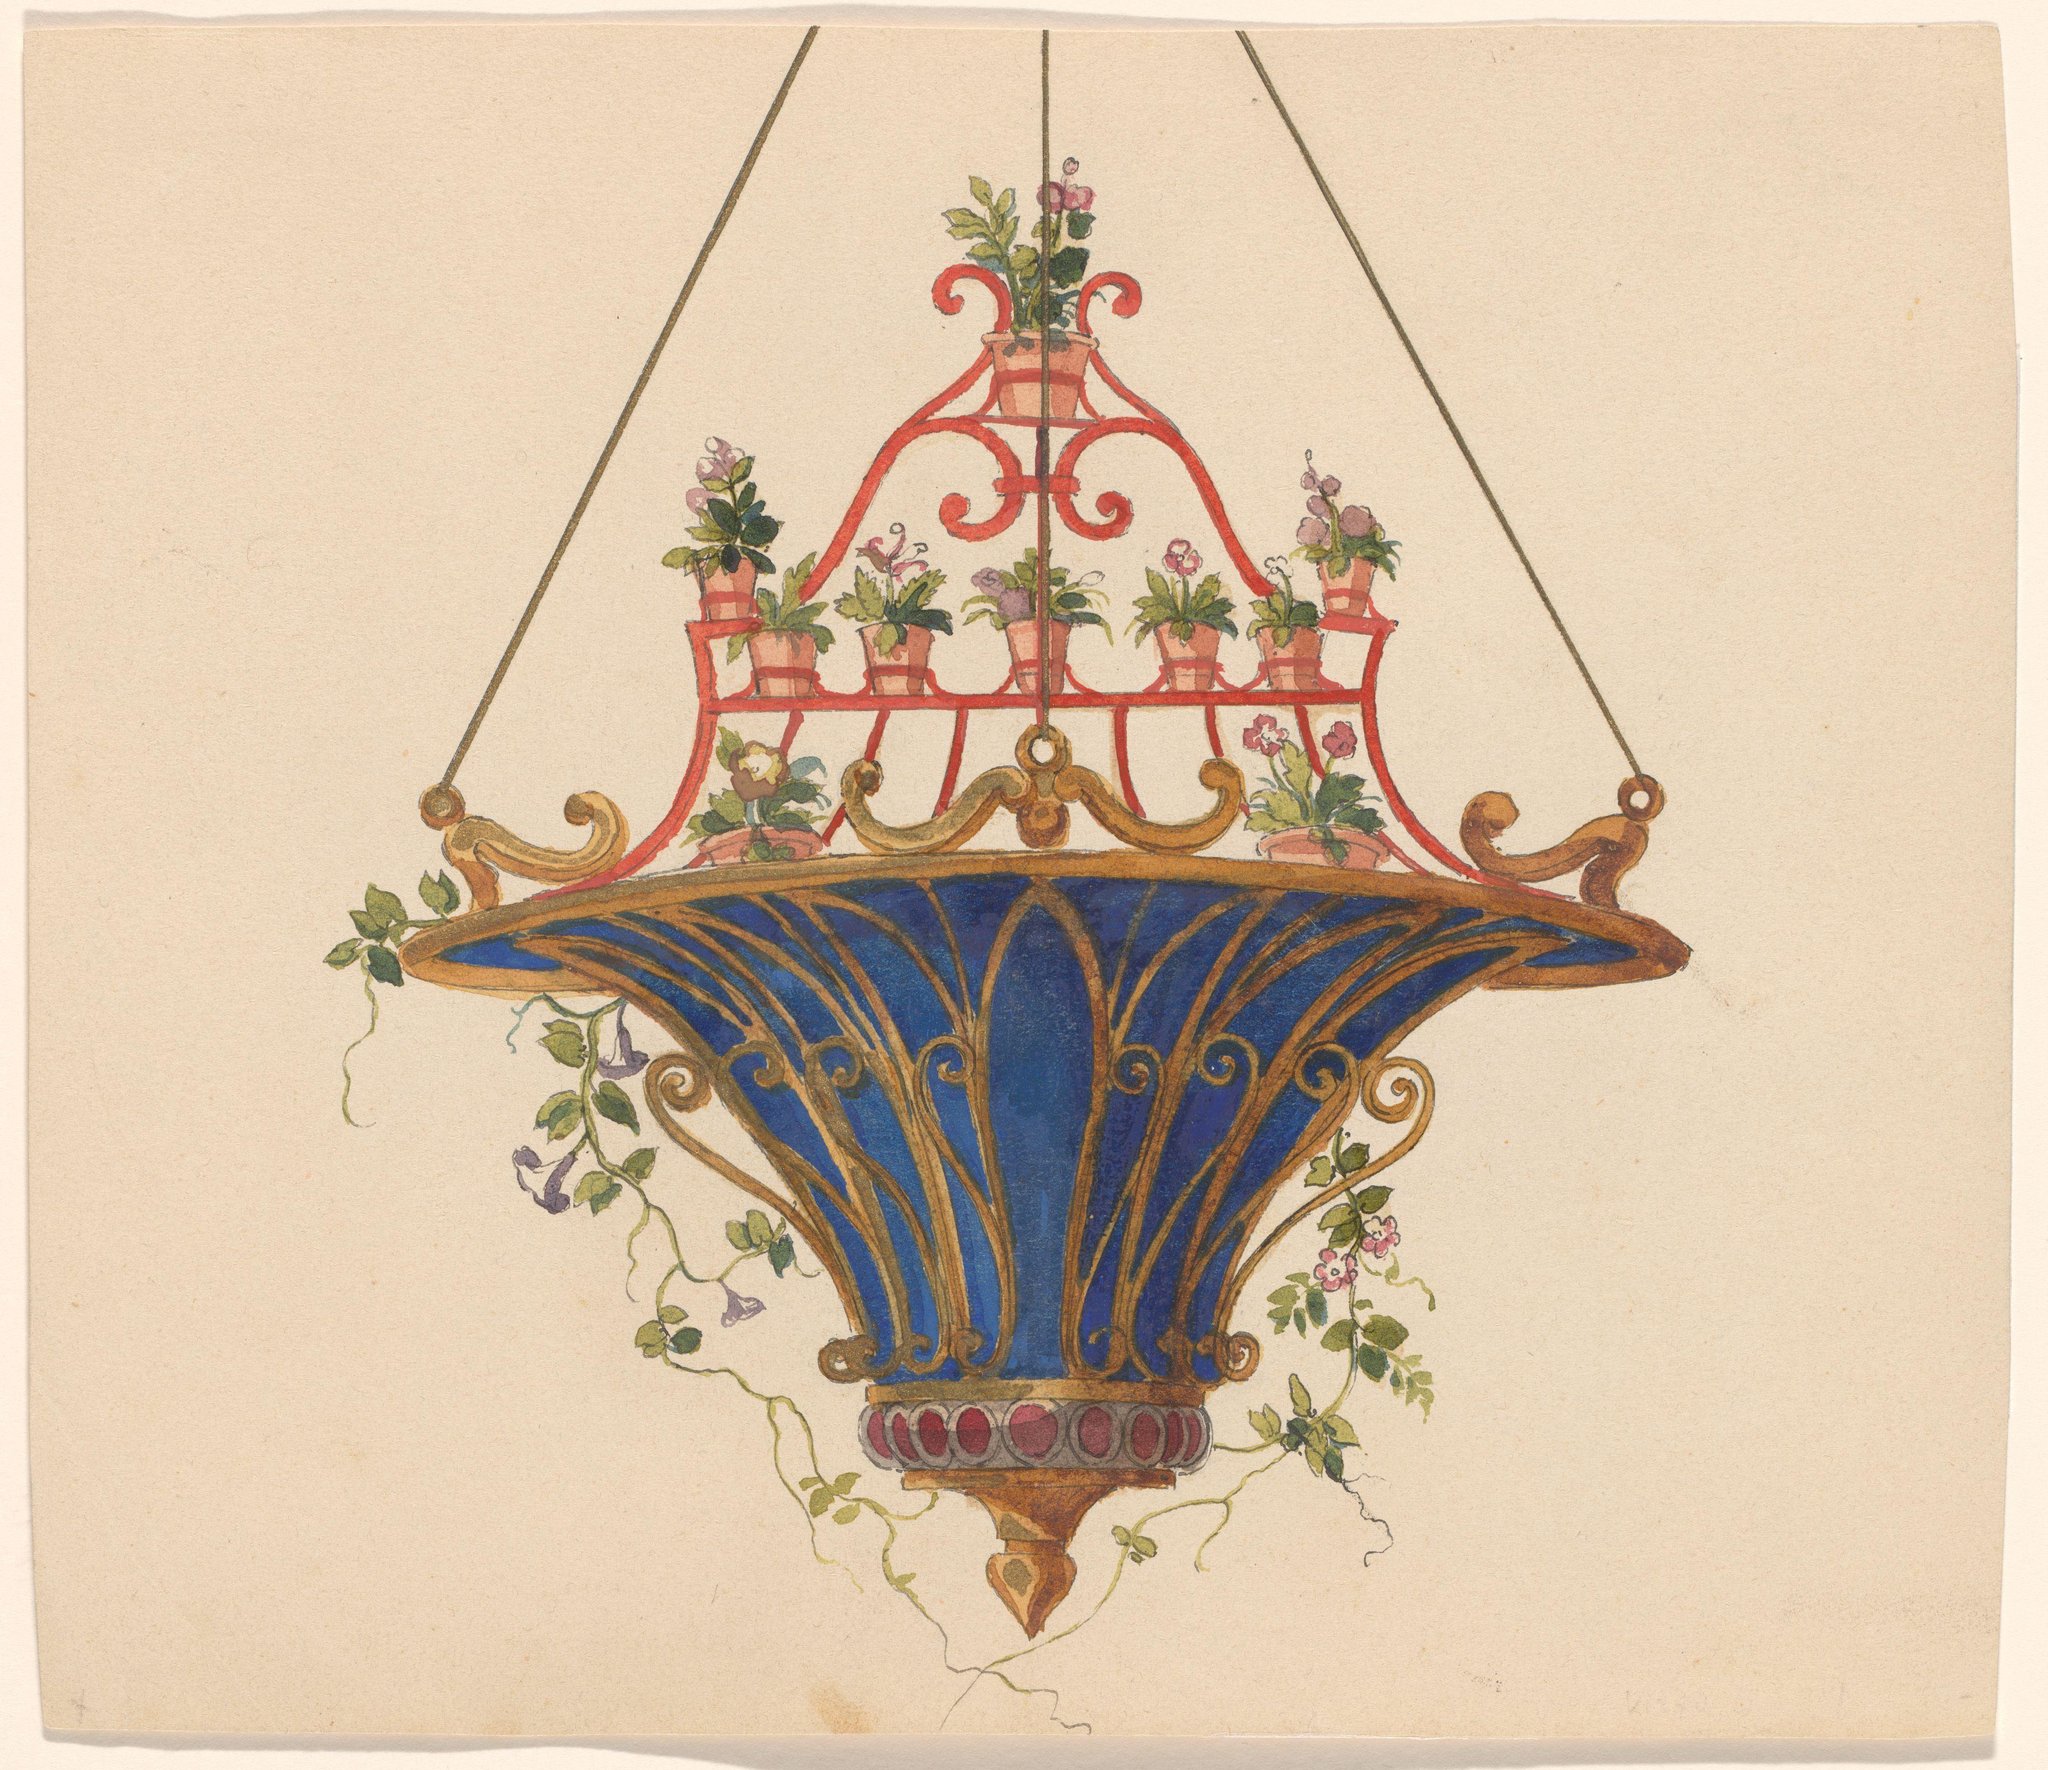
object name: design drawing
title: Jardinière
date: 1830-1850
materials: paint, ink, paper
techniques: aquarelle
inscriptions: inscription: ‘HEINRICH JENNY’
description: Hangende jardinière in de vorm van een blauwe mand met een rode opstand.